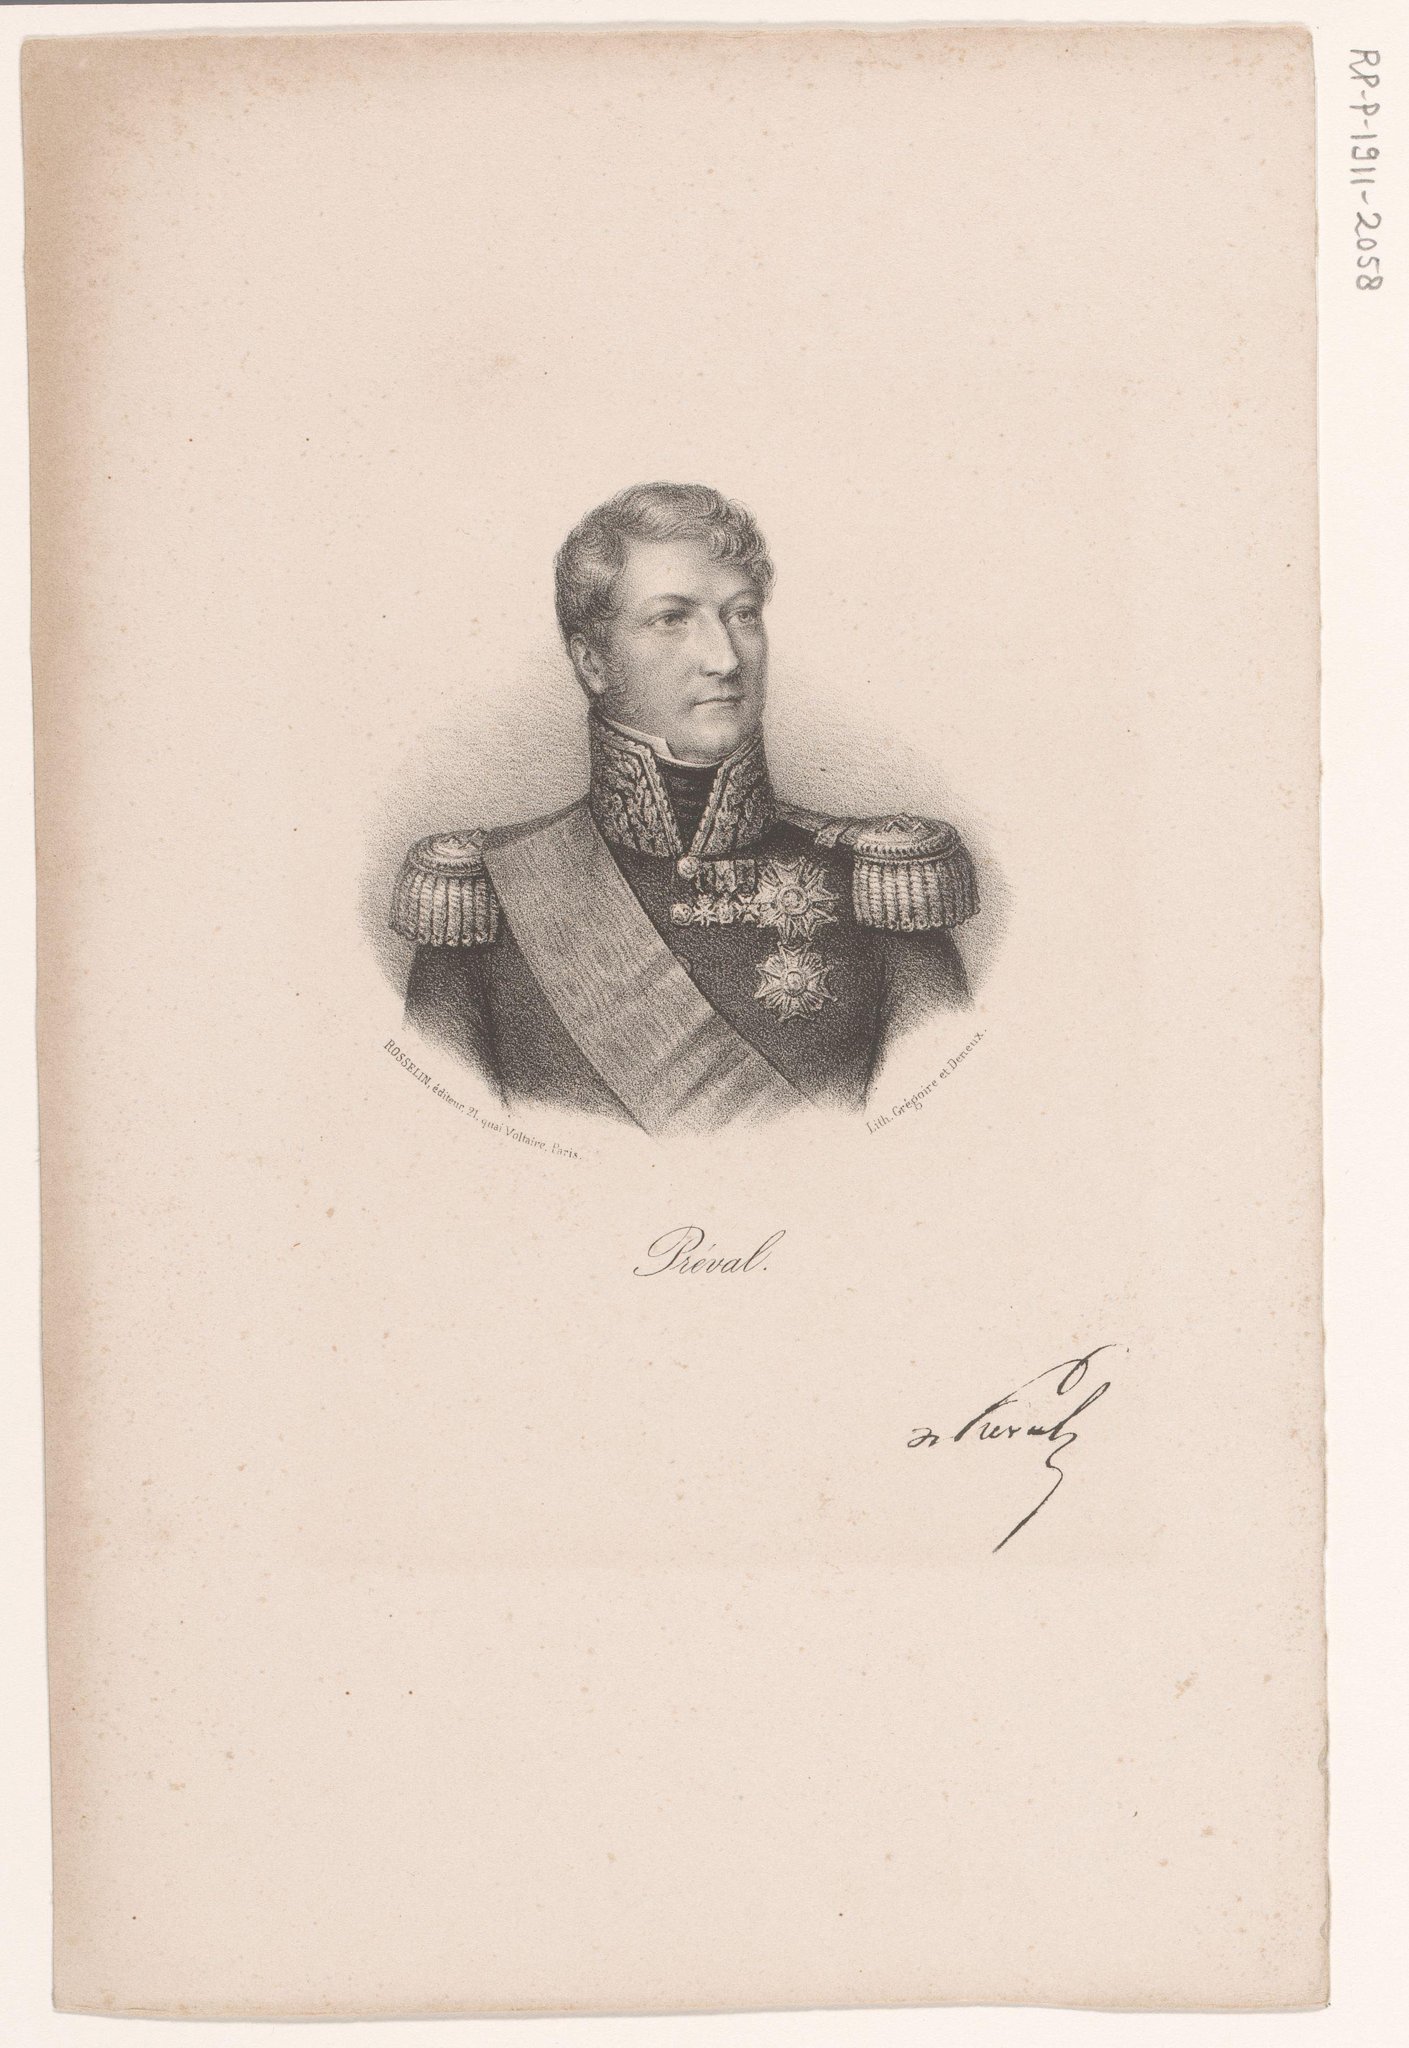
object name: print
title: Préval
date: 1844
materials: paper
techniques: lithograph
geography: paris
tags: paris, politician, historical persons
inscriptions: collector's mark: Lugt 2228a